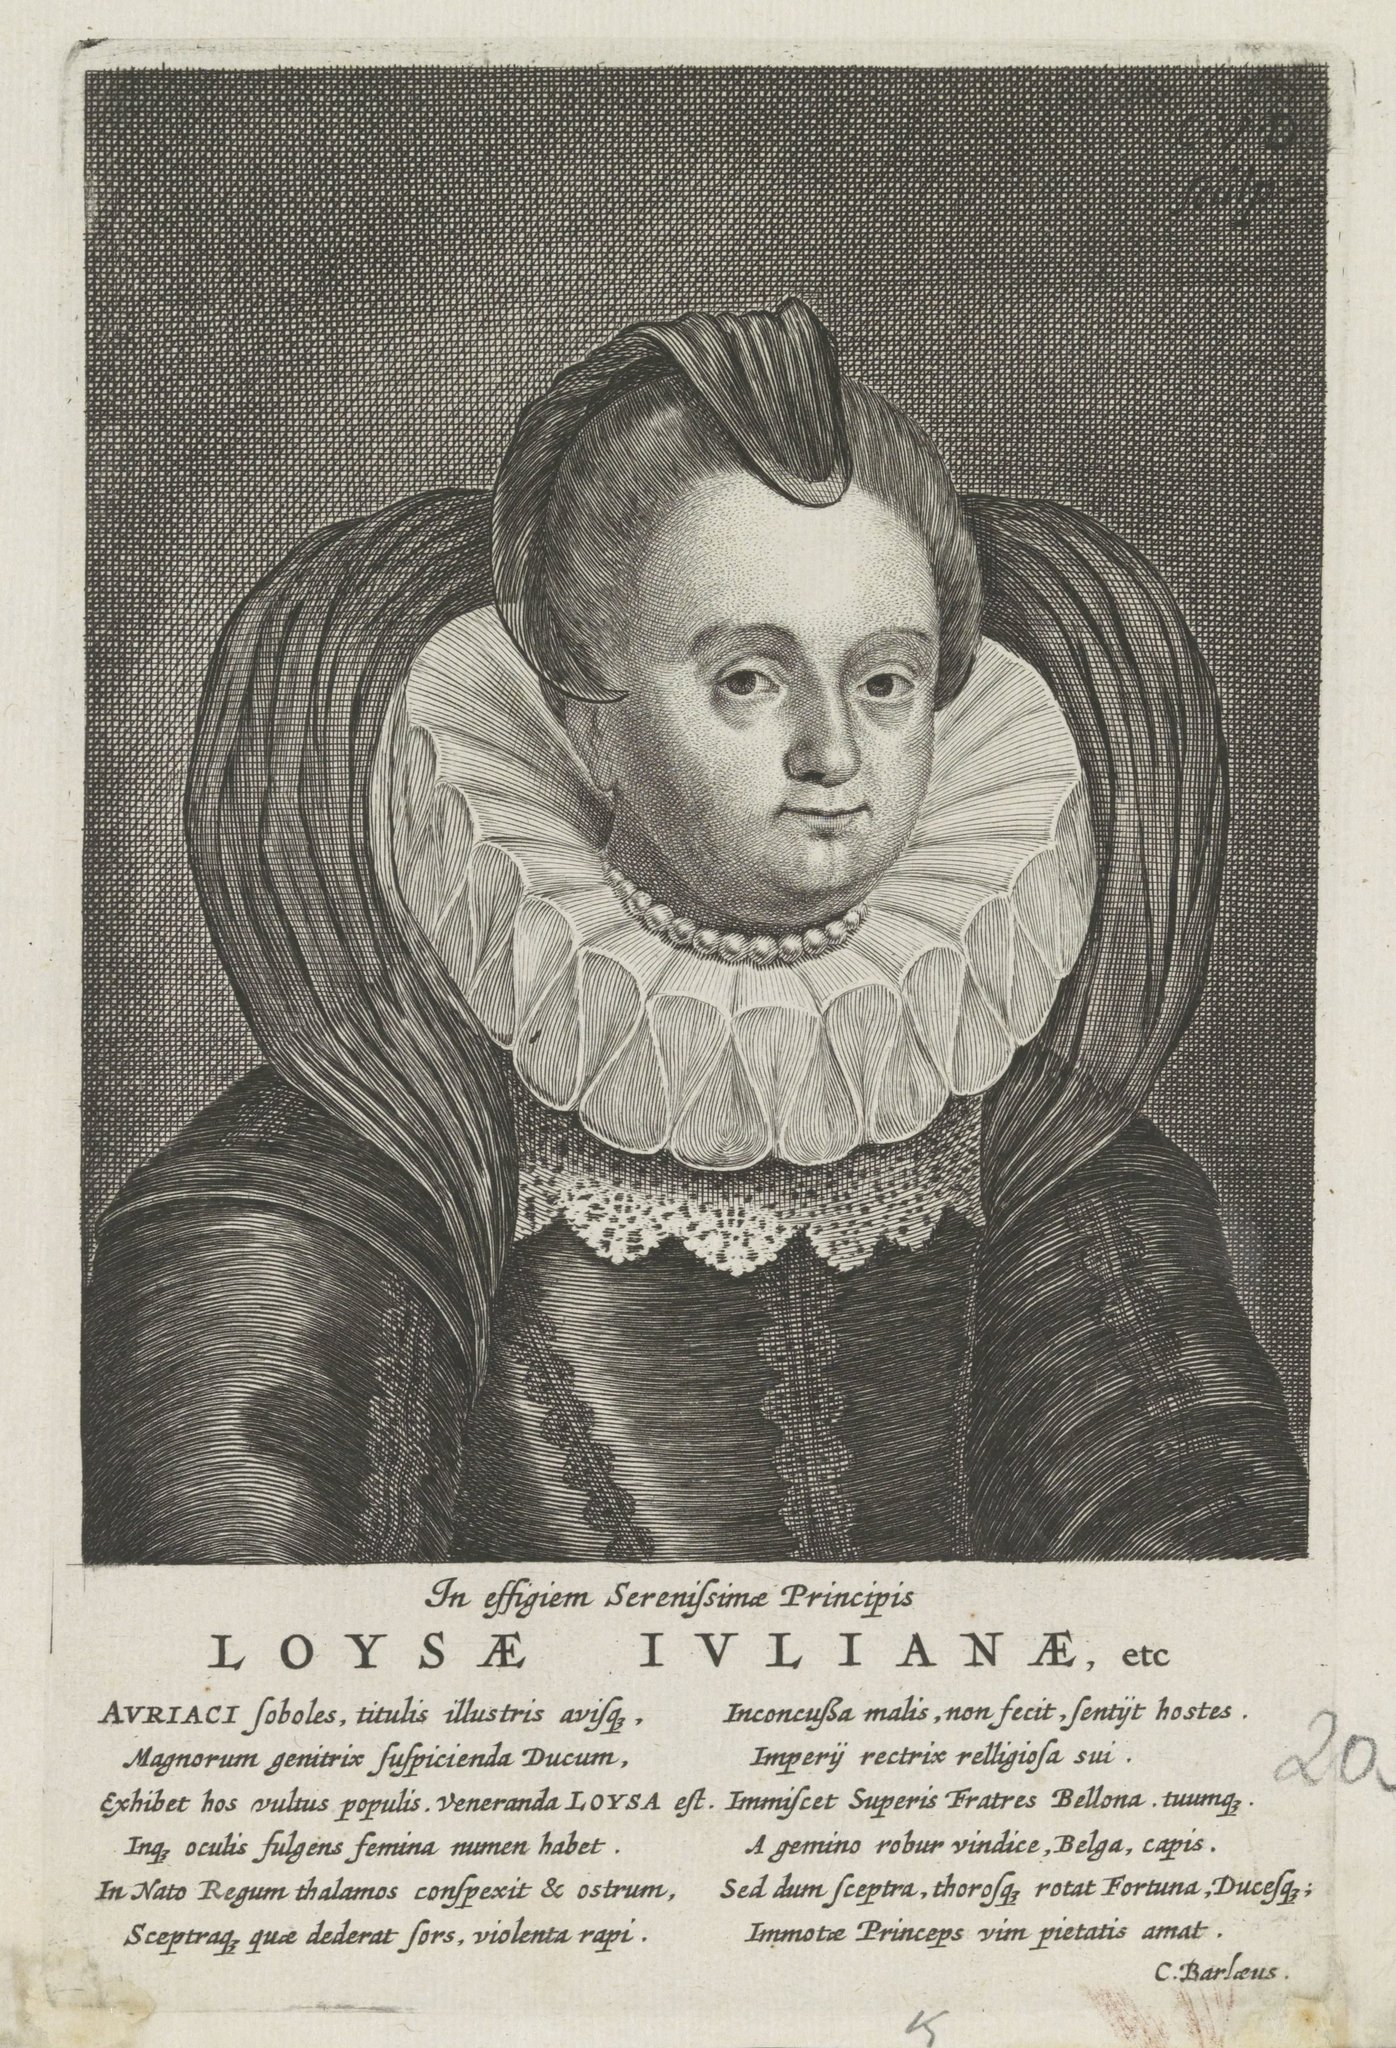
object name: print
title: Portret van Louise Juliana, prinses van Oranje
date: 1622-1665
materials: paper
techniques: engraving, etching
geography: amsterdam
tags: dordrecht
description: De hier vermelde titel verwijst naar de hoogst verkregen titel van de geportretteerde, niet per se naar de titel die de geportretteerde op deze voorstelling draagt.